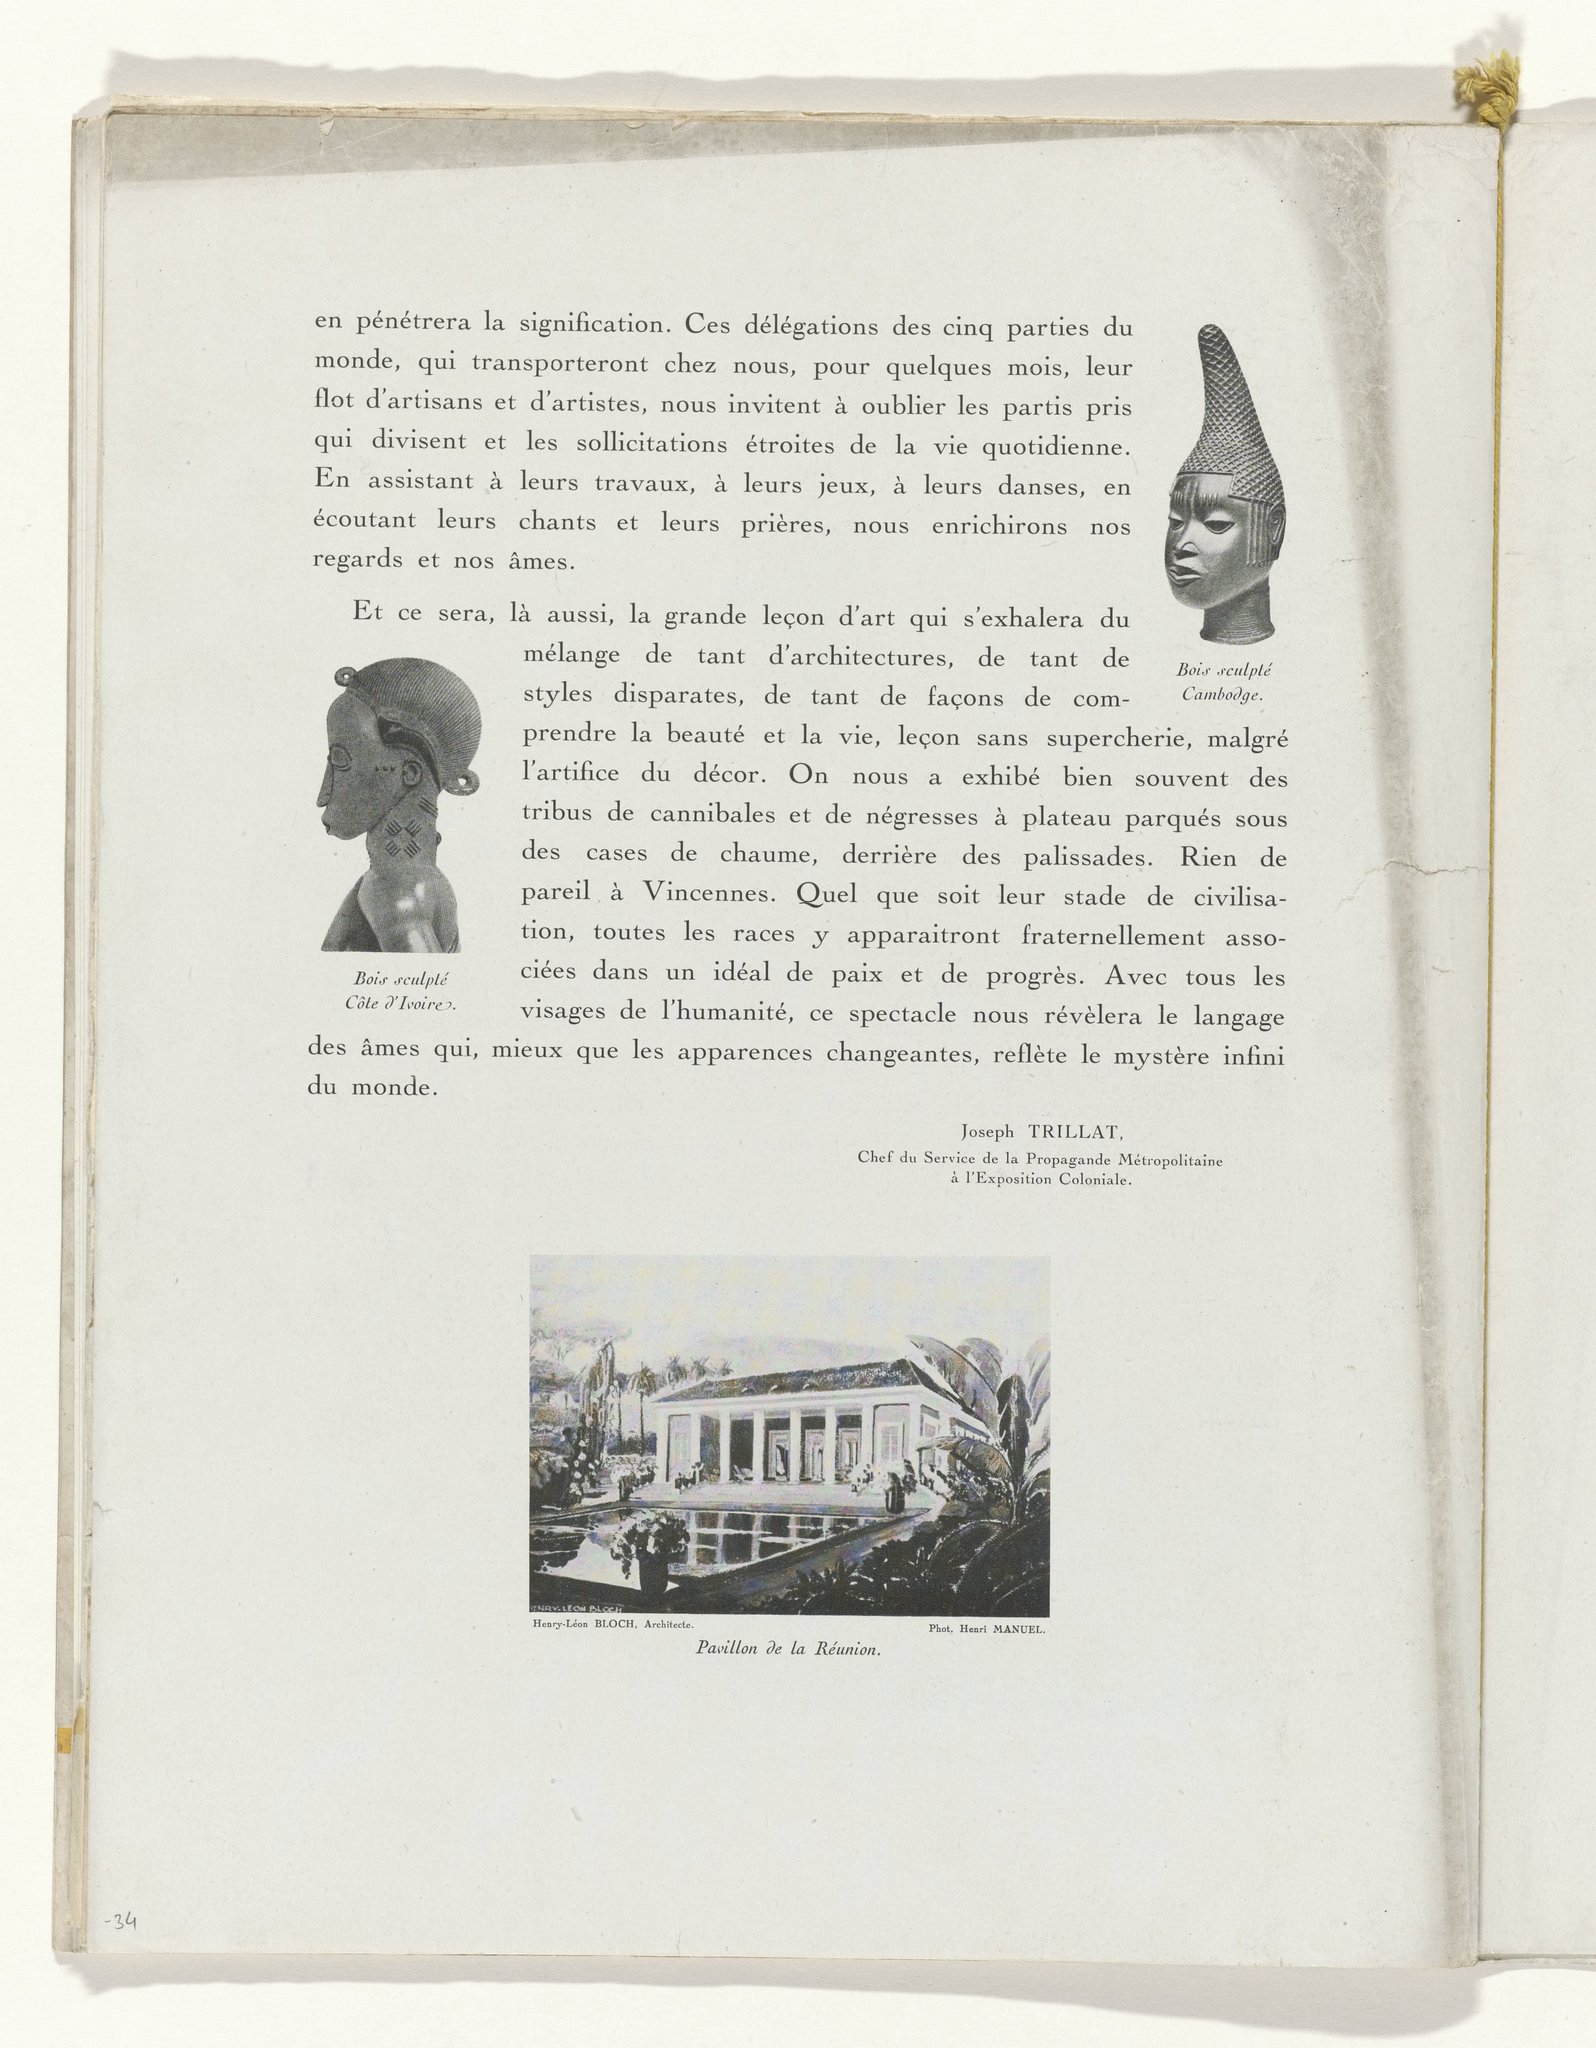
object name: fashion print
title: Art - Goût - Beauté, Feuillets de l' élégance féminine, Mai 1931, No. 129, 11e Année, p. 34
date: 1931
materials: paper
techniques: photography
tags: fashion plates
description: Vevrolg van de tekst 'Une vision d'art: l'Exposition Coloniale Internationale de Paris' met afbeeldingen van twee houten sculpturen en het 'Pavillon de la Réunion' ontworpen door Henry-Léon Bloch (architect). Pagina uit het modetijdschrift Art-Goût-Beauté (1920-1933).